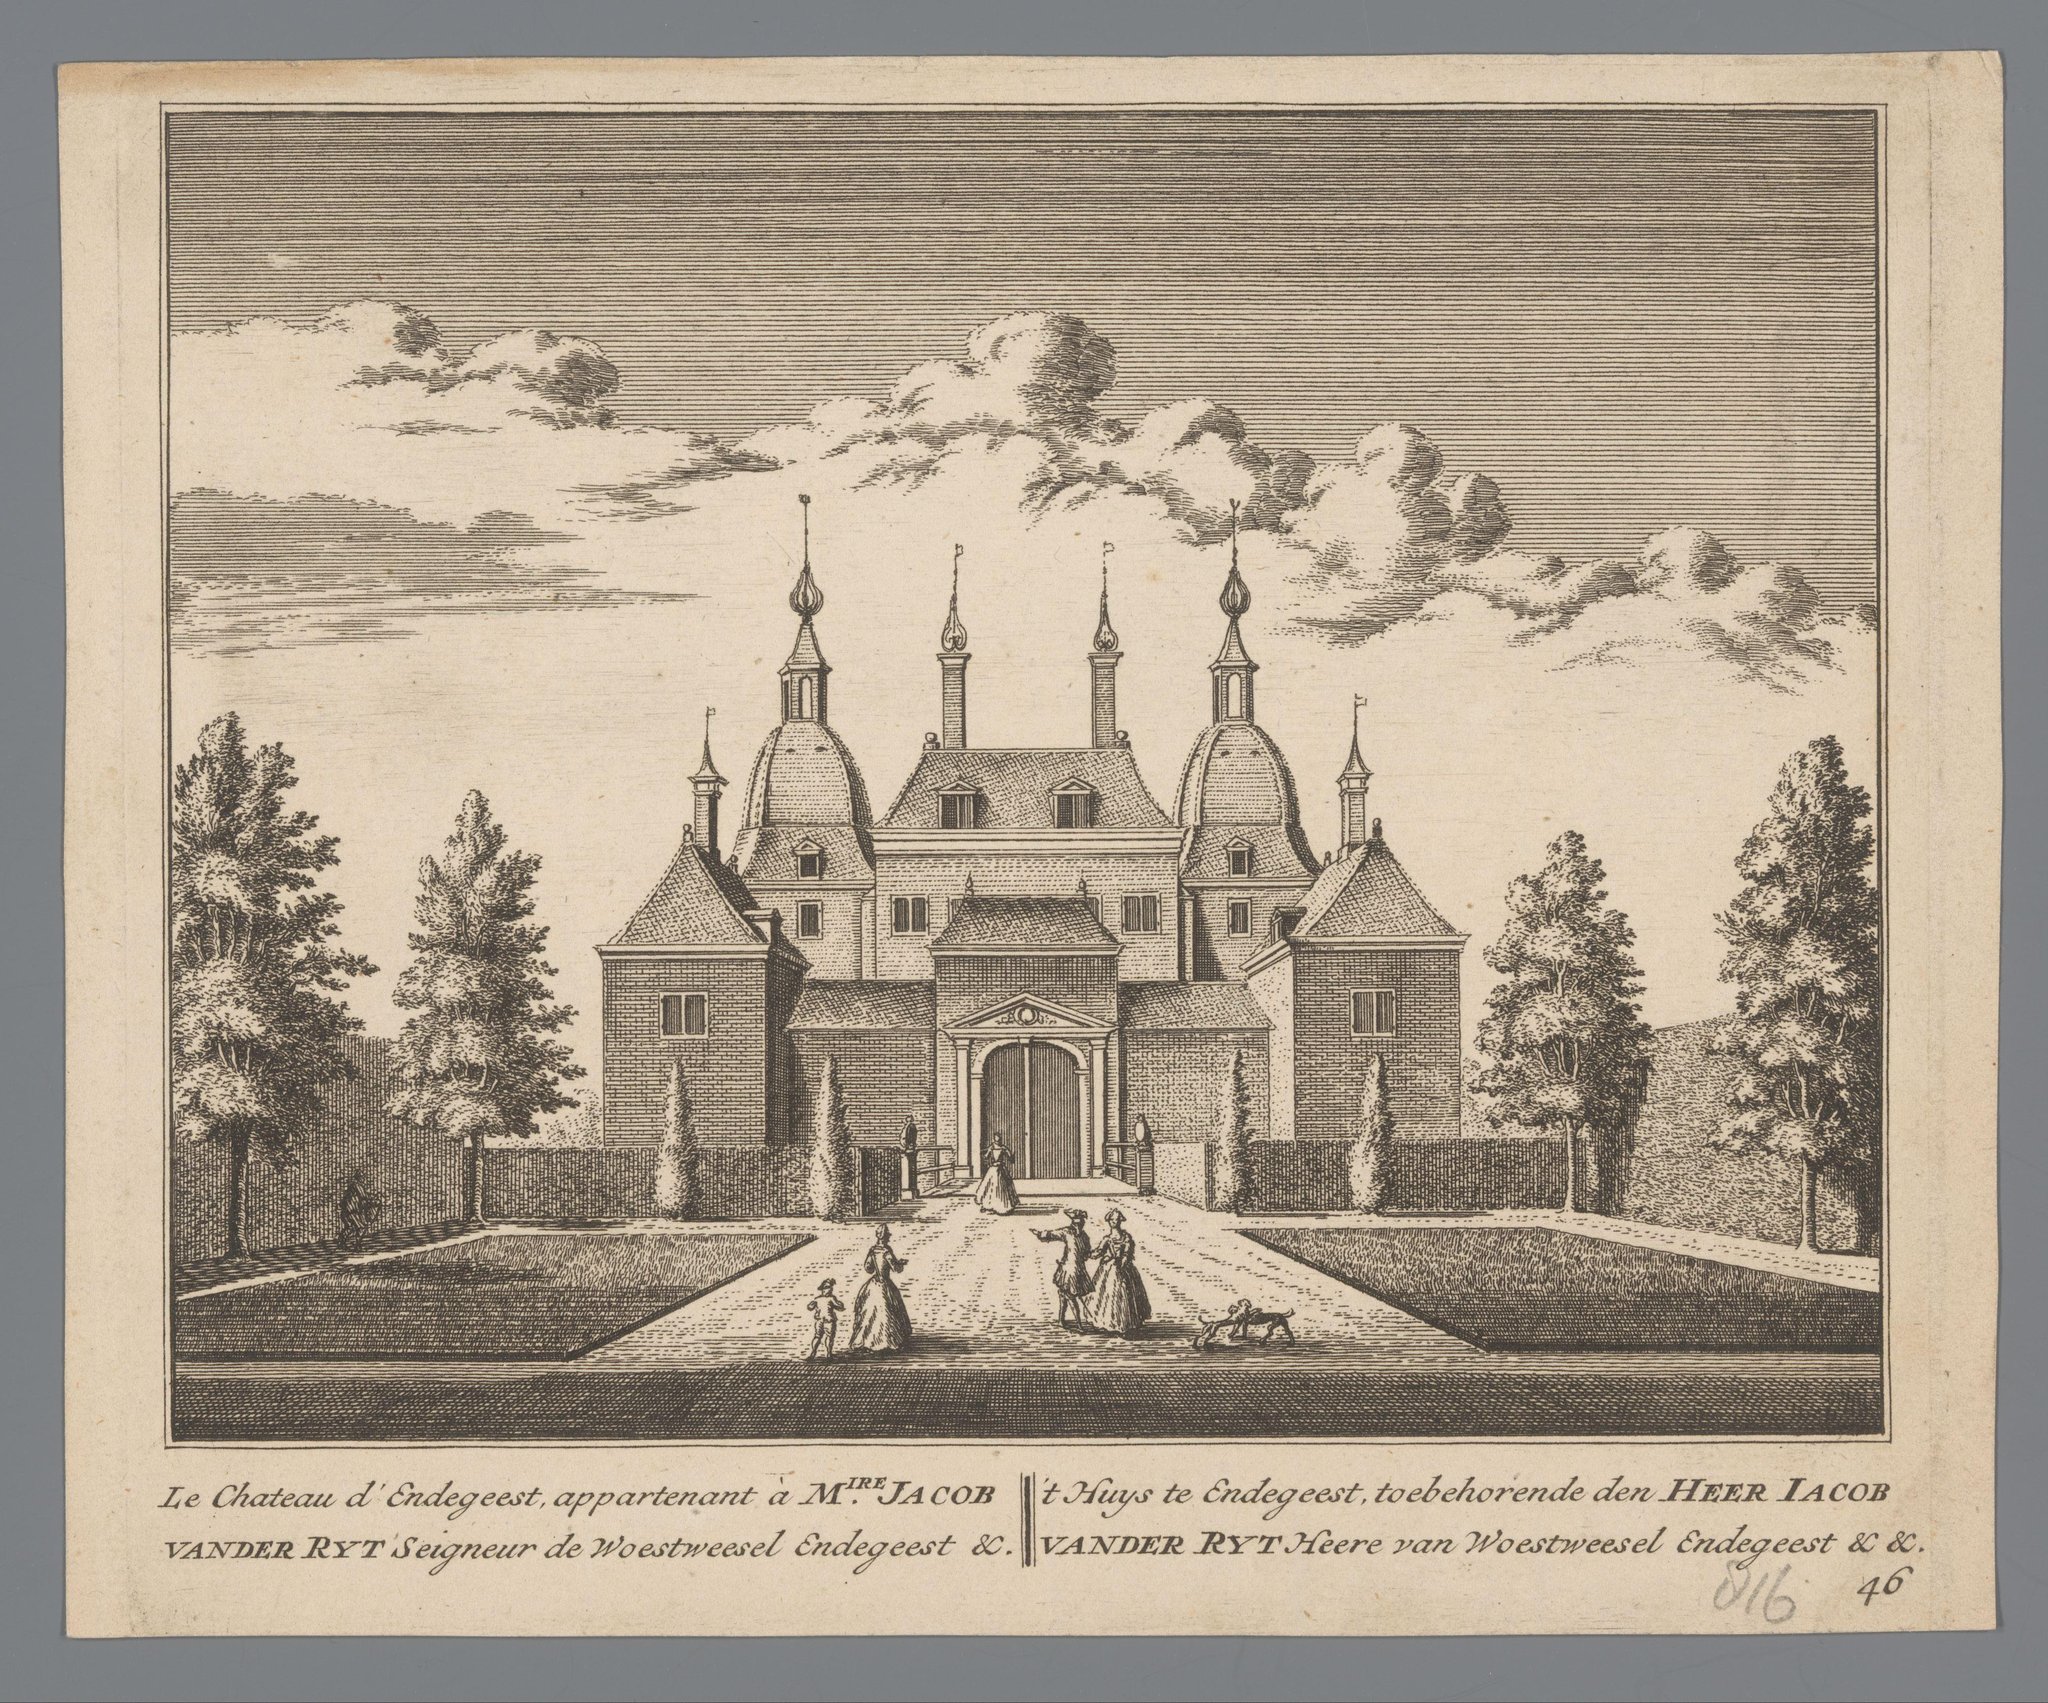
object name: book illustration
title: Le chateau d'Endegeest, appartenant à M.ire Jacob vander Ryt seigneur de Woestweesel Endegeest &c. / 't Huys te Endegeest, toebehorende den heer Jacob vander Ryt Heere van Woestweesel Endegeest &c.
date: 1731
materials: paper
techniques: engraving, etching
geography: amsterdam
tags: castle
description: Prent uit: Rademaker, Abraham. Rhynlands fraaiste gezichten (...). Amsterdam: Leonard Schenk, 1732, nr. 46.